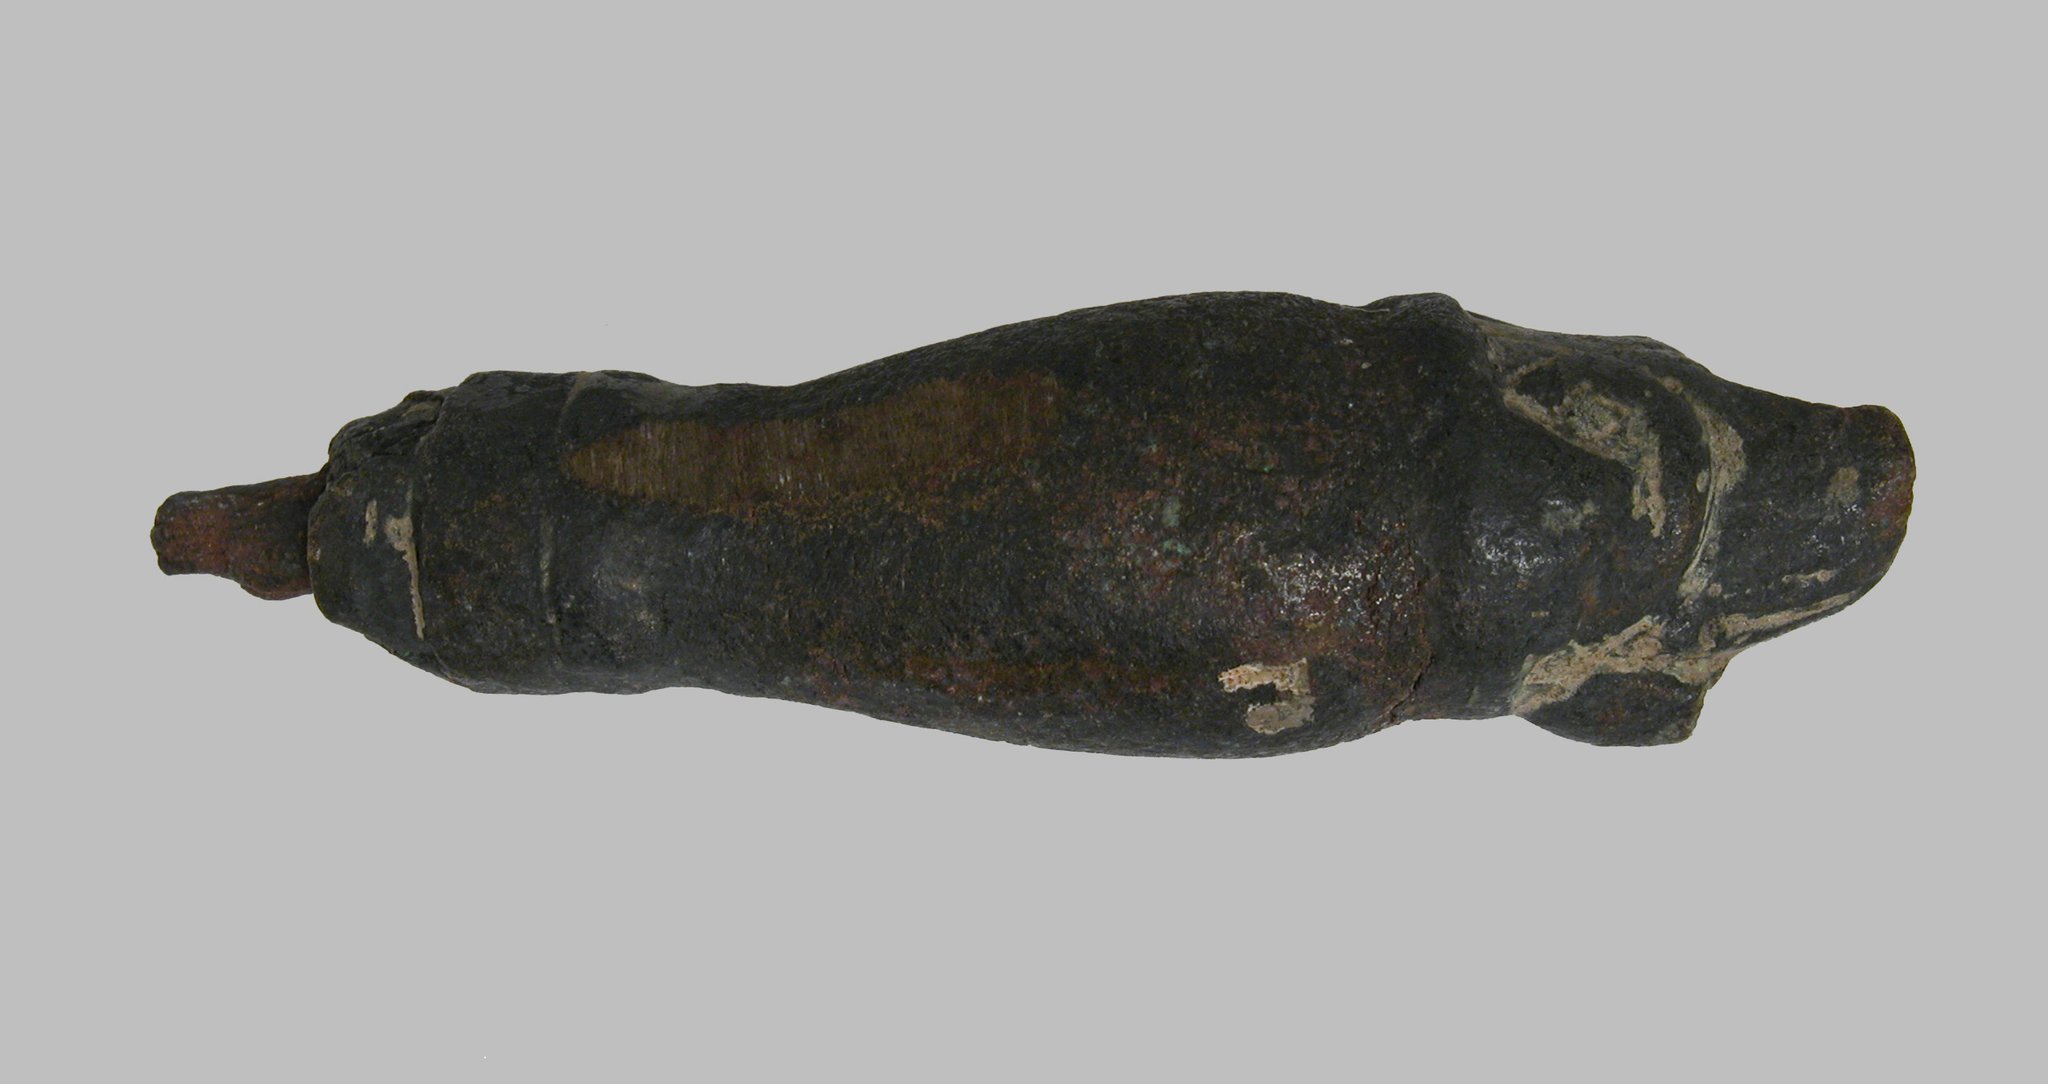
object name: key handle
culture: roman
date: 1-700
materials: copper alloy, iron